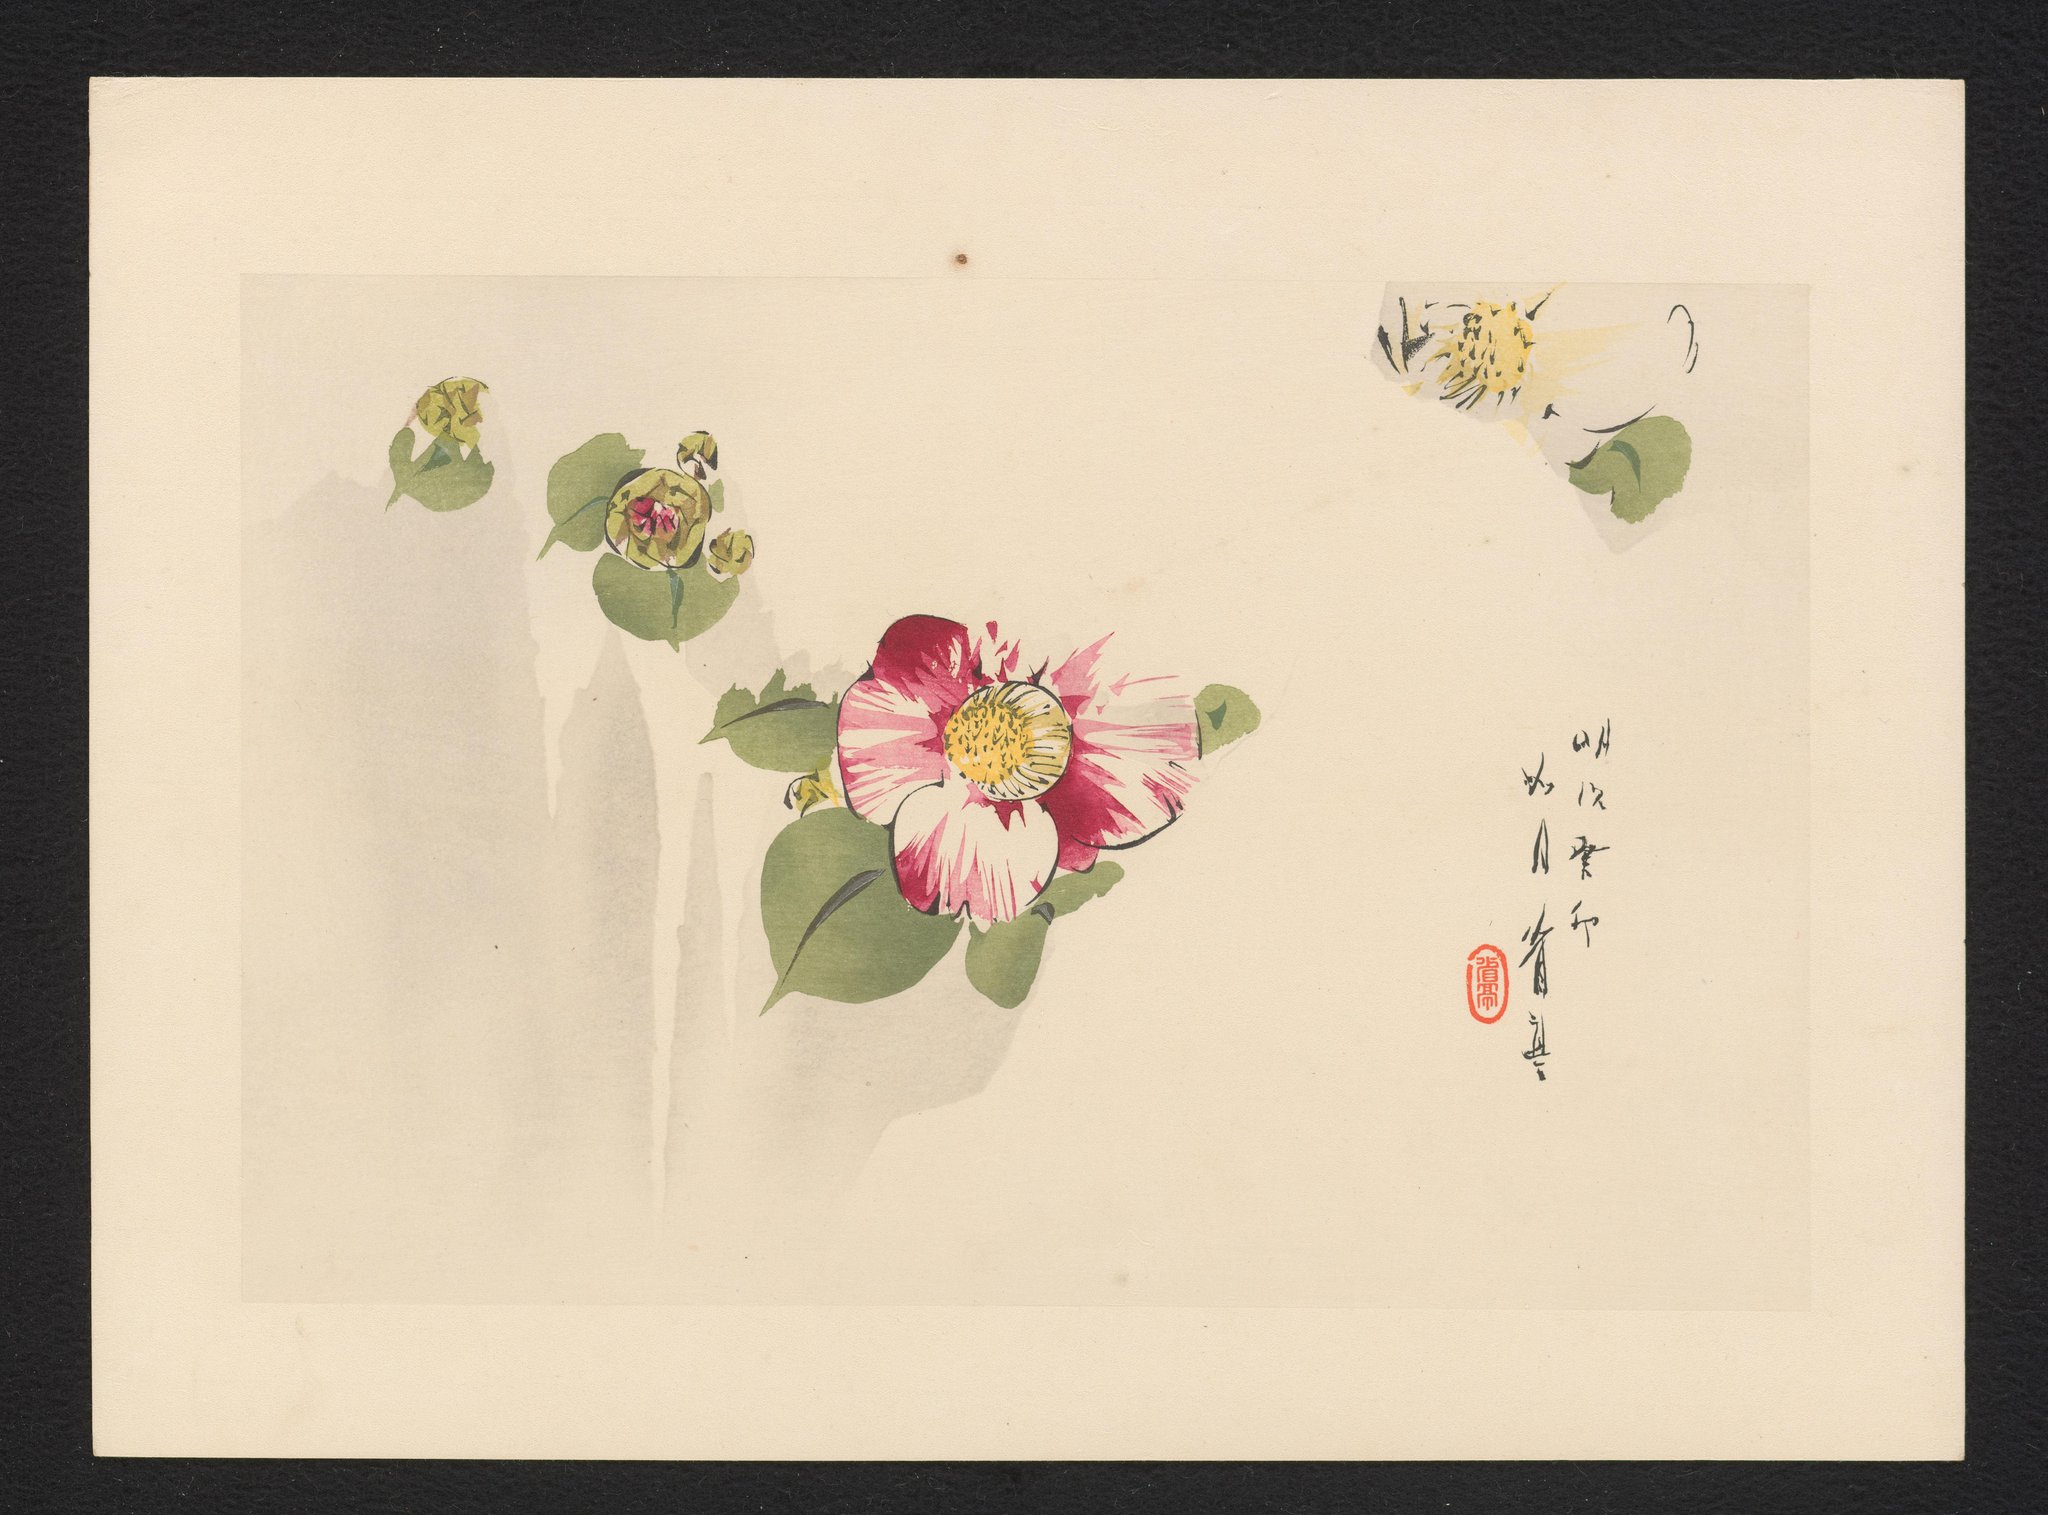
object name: print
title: Bloemen en vogels door Seitei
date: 1916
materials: paper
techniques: woodcut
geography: tokyo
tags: flowers, snow